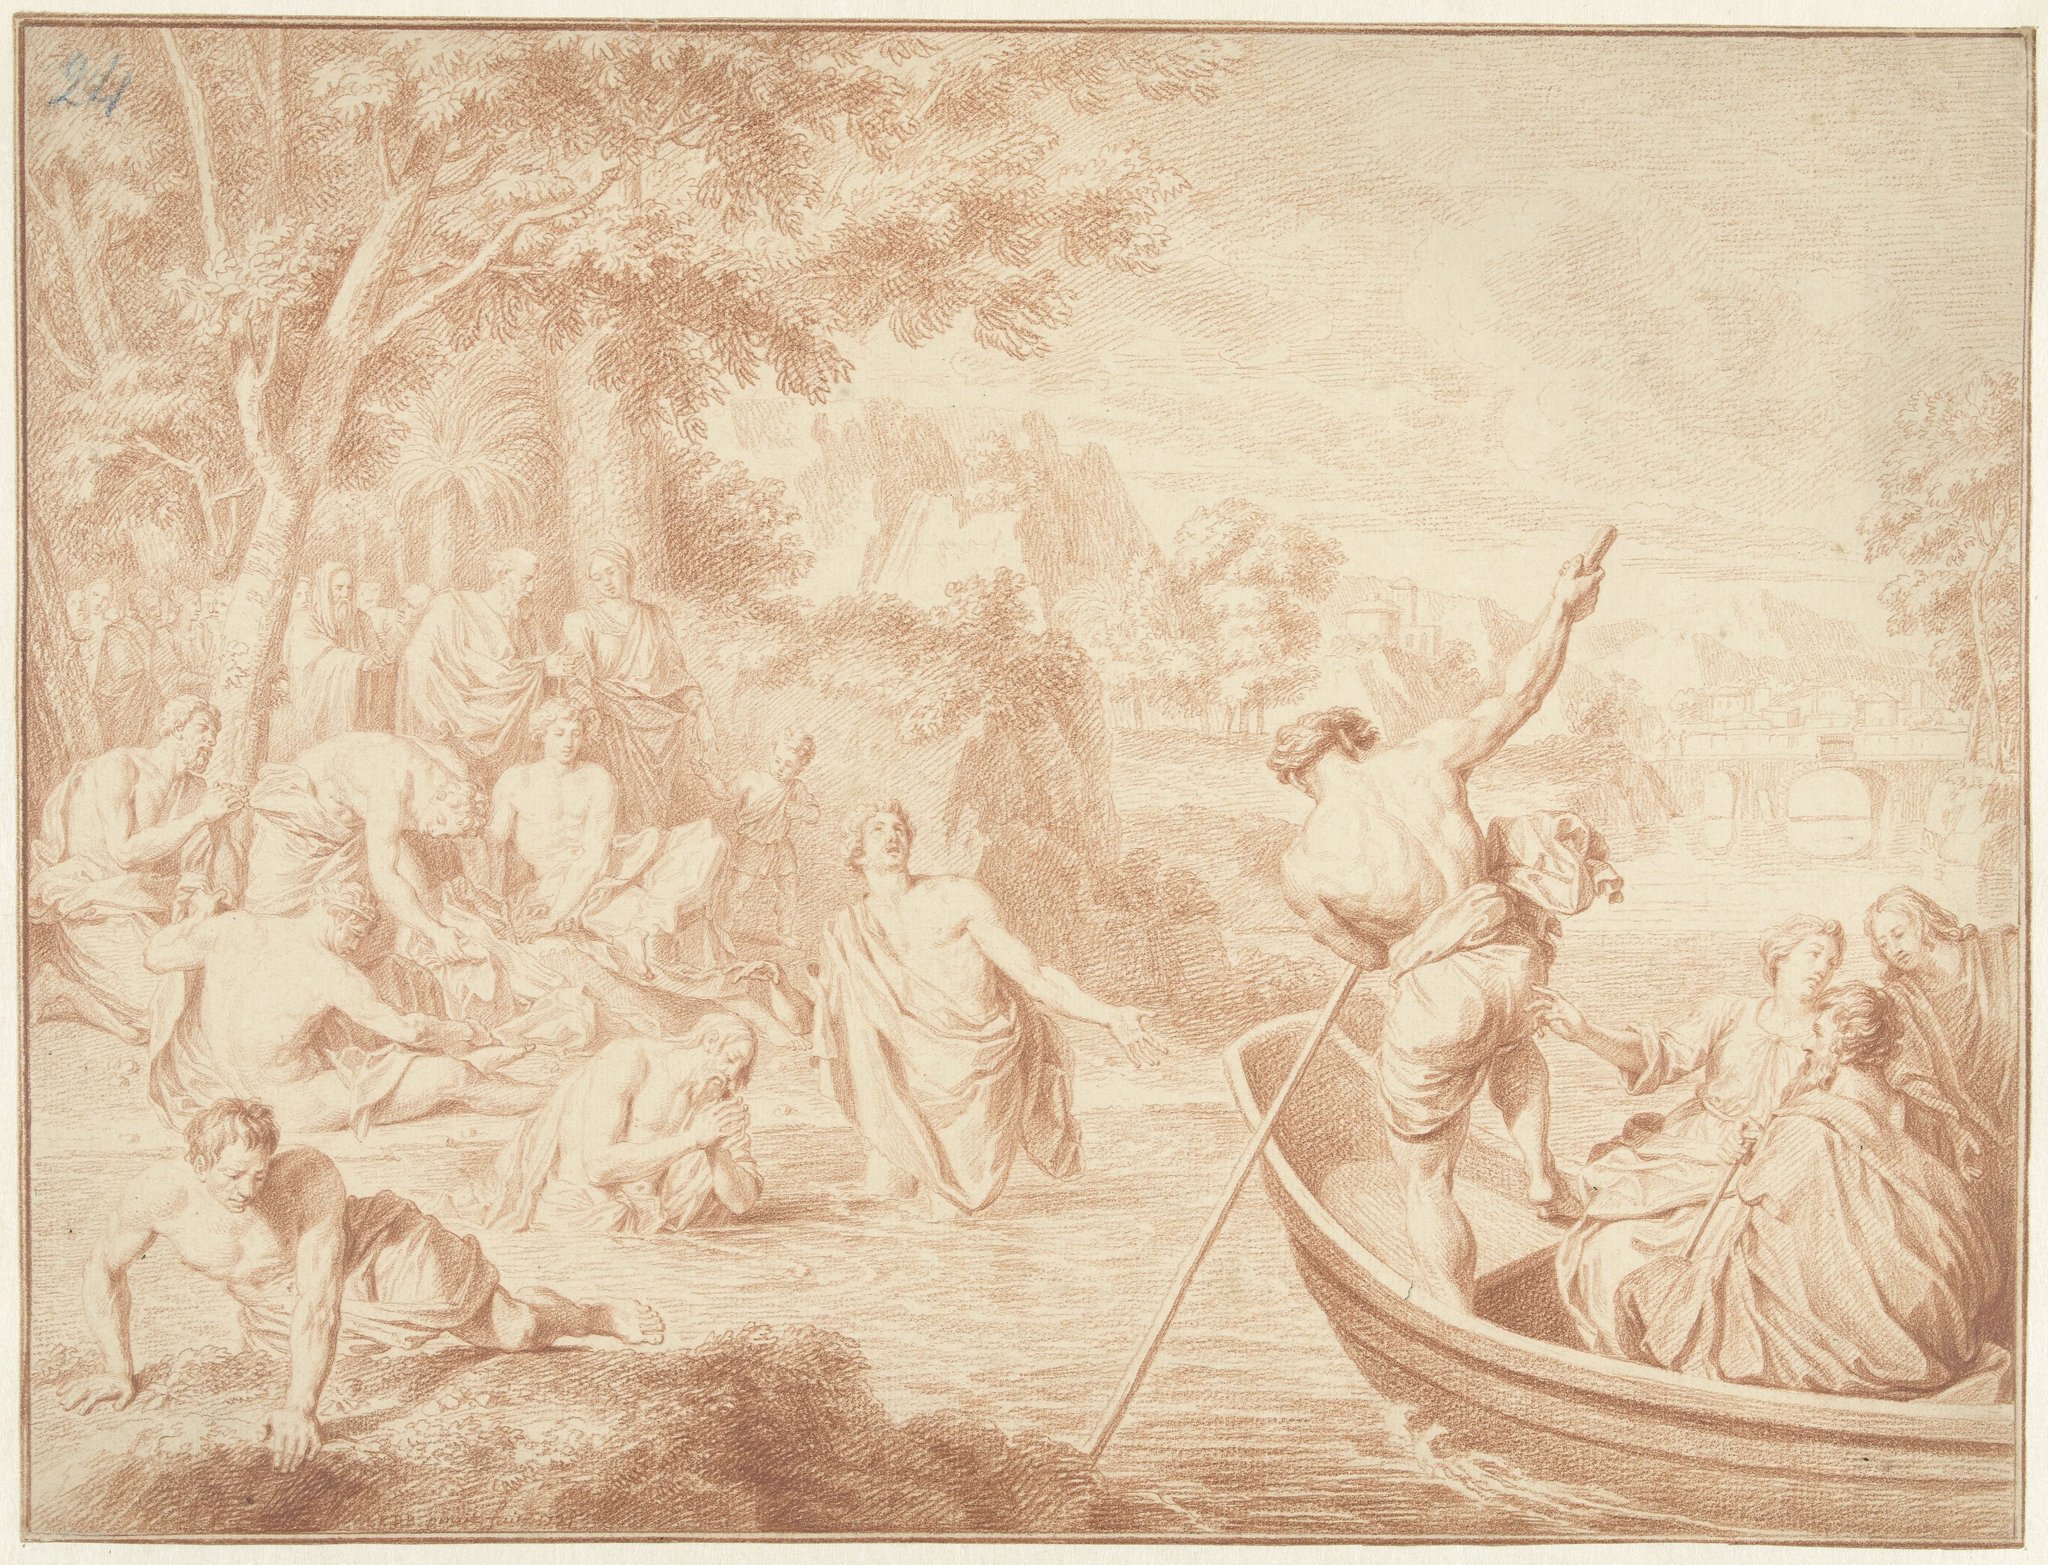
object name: drawing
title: De doop van Christus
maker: louis fabritius dubourg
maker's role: draughtsman, print maker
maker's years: 1693-1775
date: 1725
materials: chalk, paper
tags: baptism of christ in the river jordan: john the baptist pouring out water on christ's head: the holy ghost descends